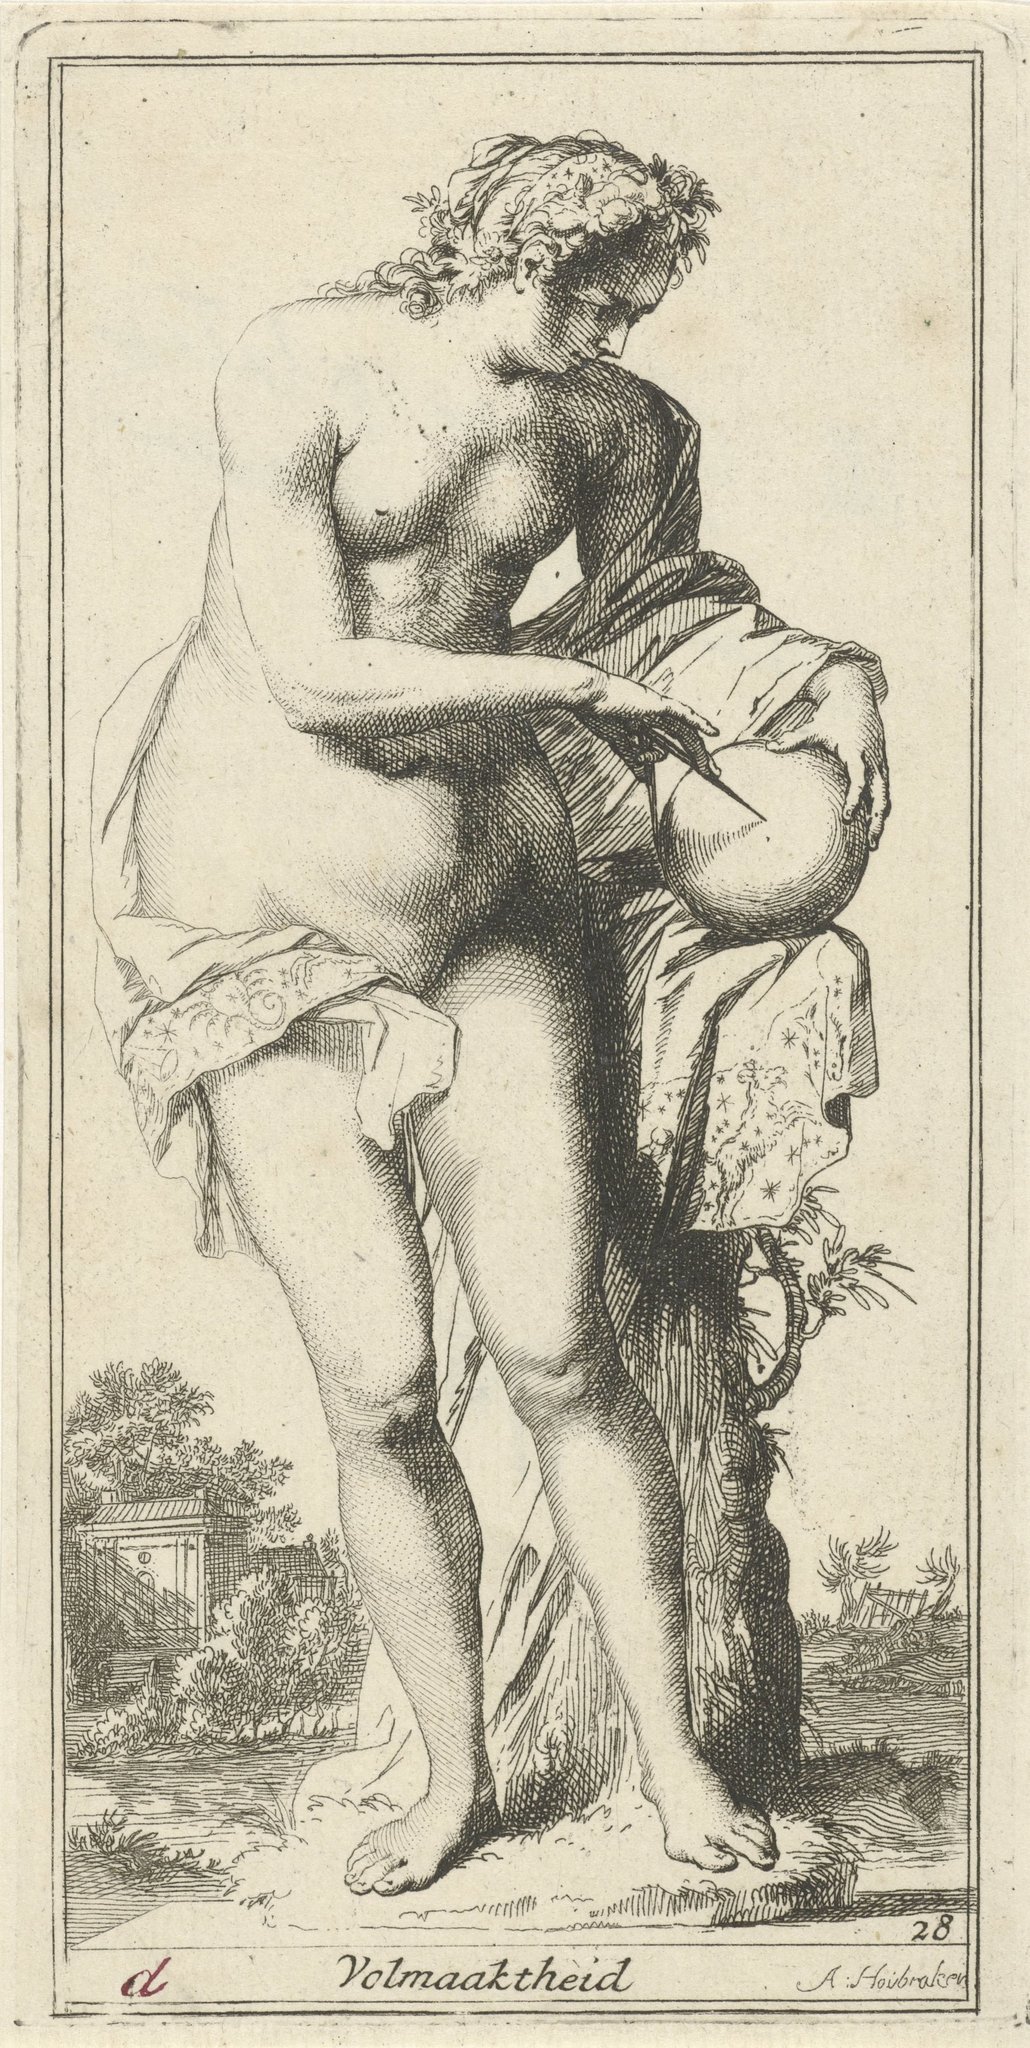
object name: print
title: Personificatie van de volmaaktheid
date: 1710-1719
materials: paper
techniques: engraving, etching, pen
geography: amsterdam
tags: circle symbolizing god's perfectness, sphere, globe ~ stereometry, measuring-instruments, perfection, completeness; 'perfettione', 'operatione perfetta' (ripa)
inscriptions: inscription: ‘d’, collector's mark: Lugt 2228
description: Een naakte vrouwfiguur als personificatie van de volmaaktheid, met in haar handen een bol die zij opmeet met een passer. Op het stuk draperie om haar heen enkele tekens van de dierenriem. Prent uit een serie van 41 zinnebeelden.